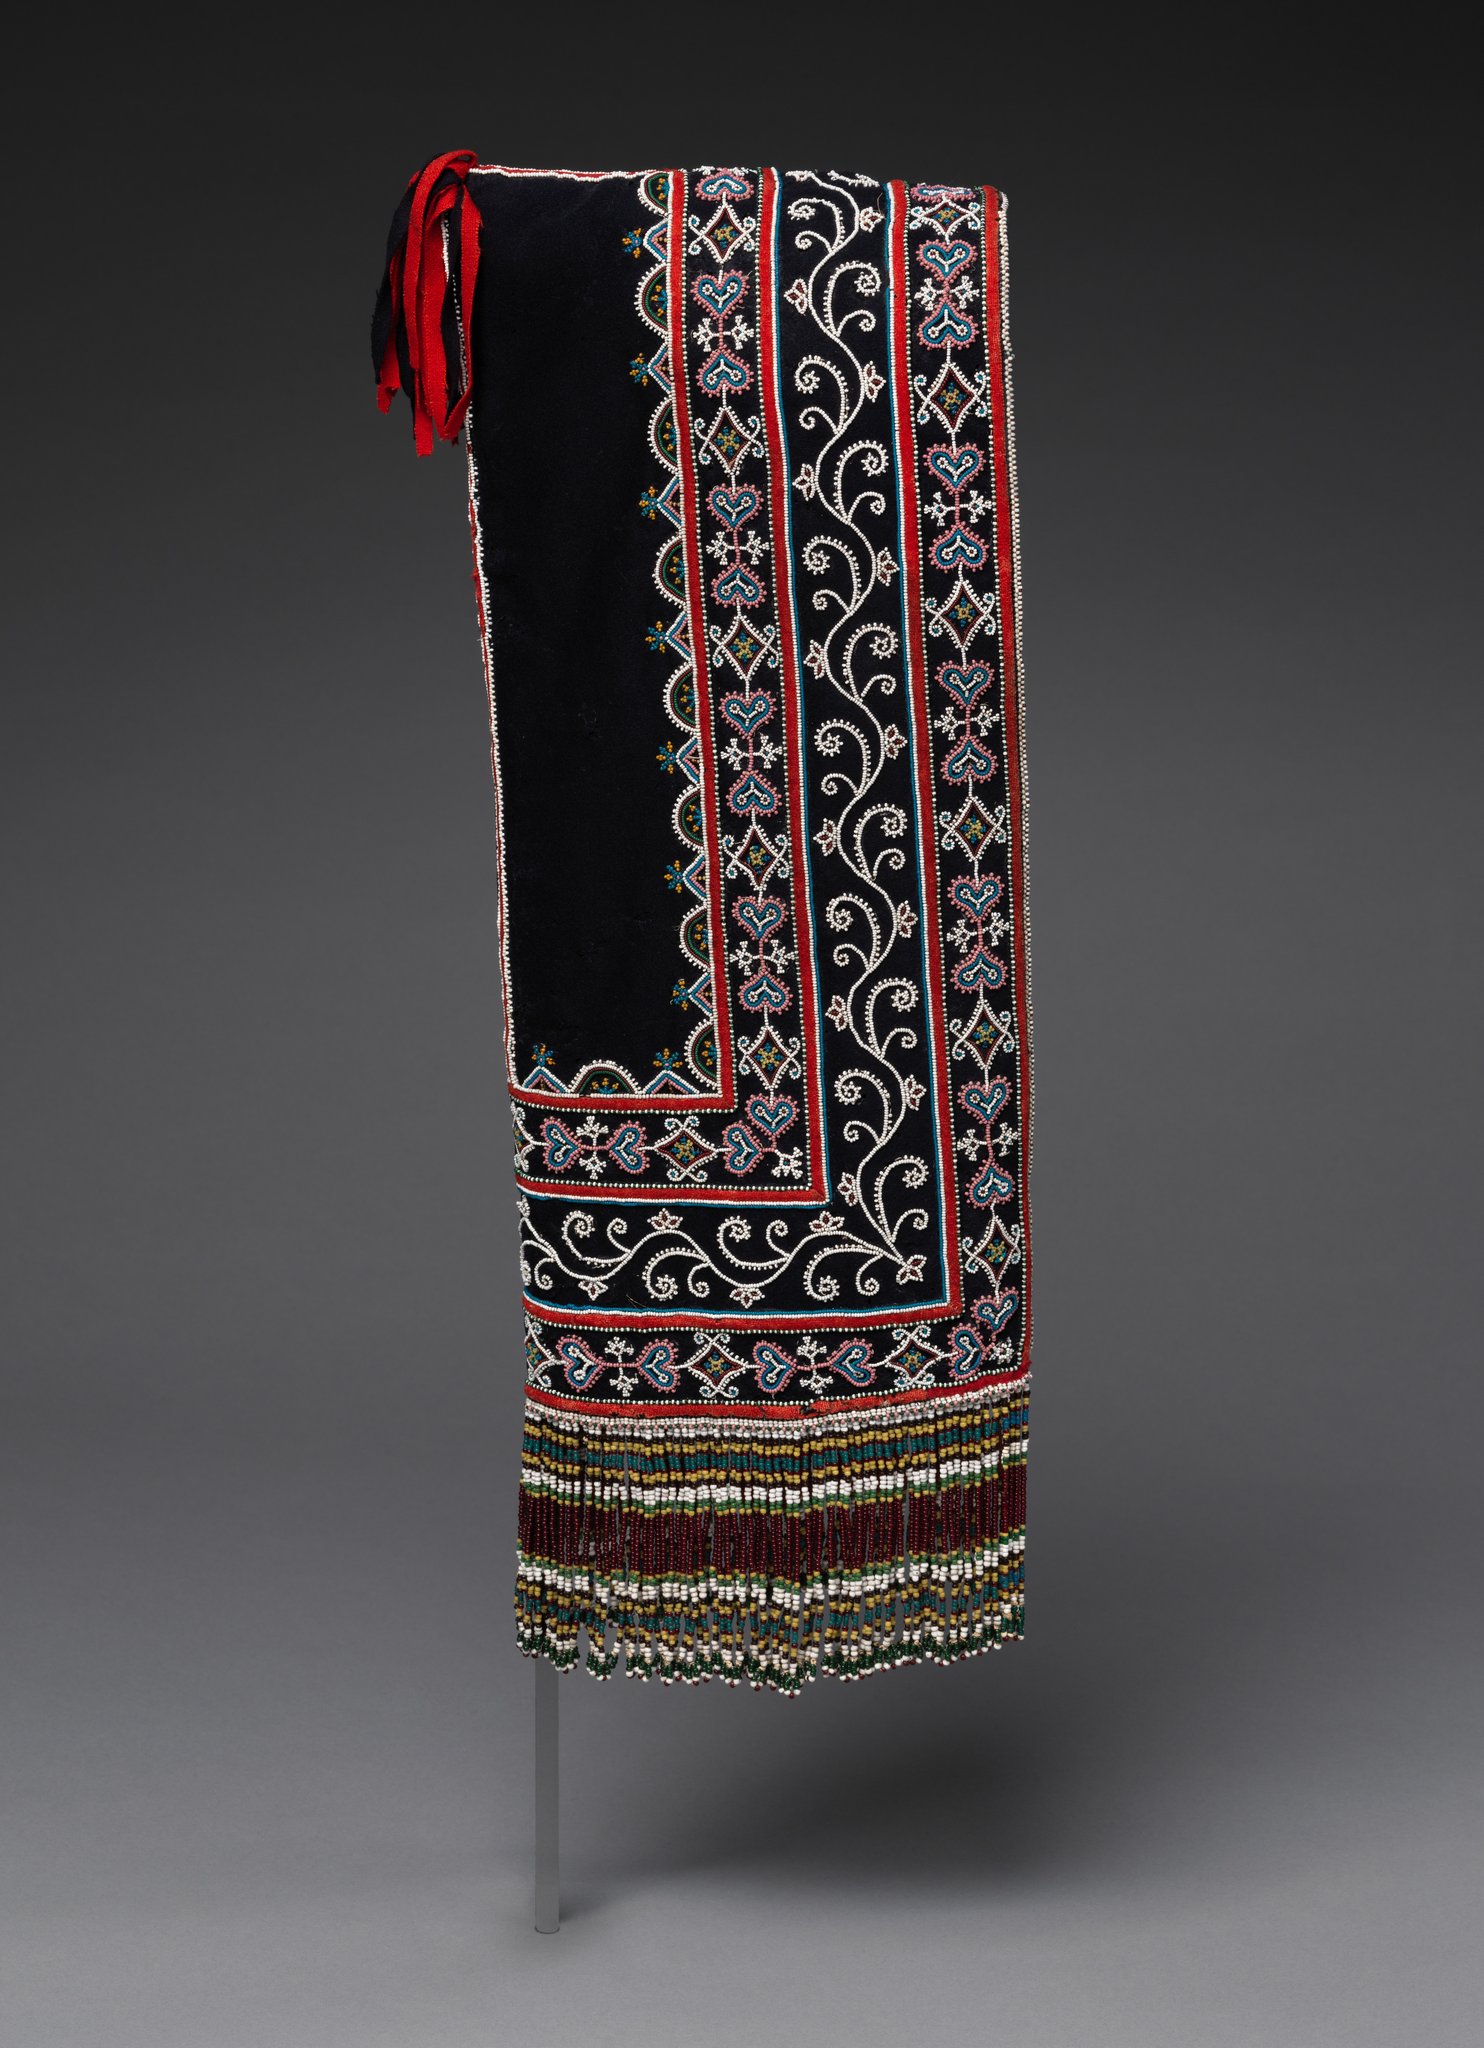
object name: hood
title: Woman's hood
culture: james bay cree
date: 1840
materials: textile, glass, ribbon, silk, wool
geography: canada